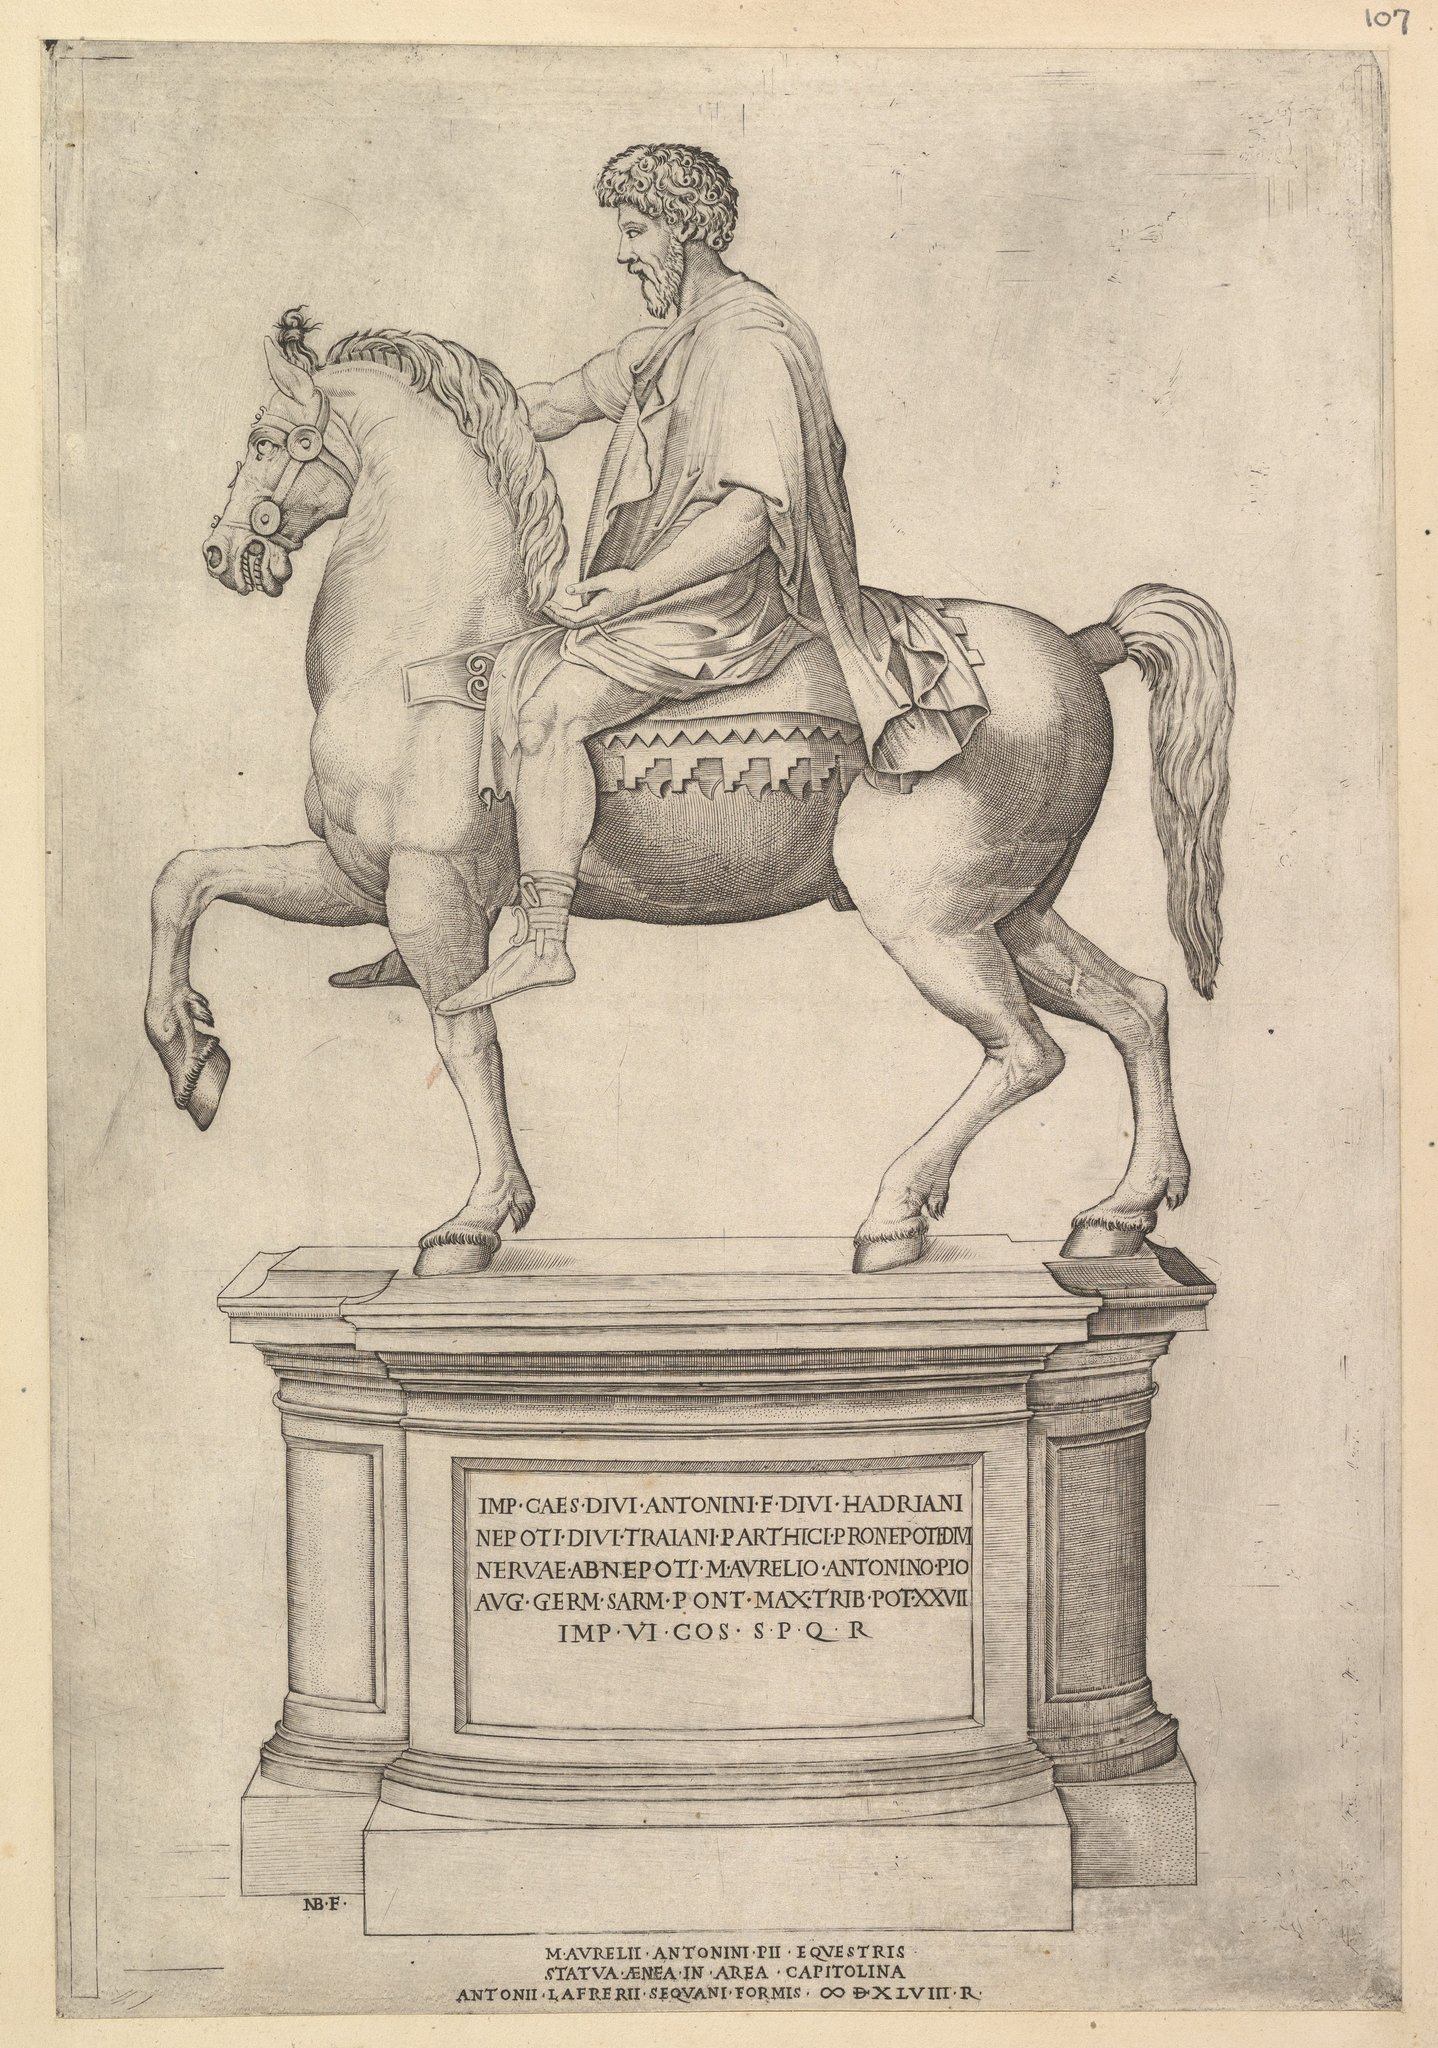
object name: print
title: Marcus Aurelius, from "Speculum Romanae Magnificentiae"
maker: nicolas beatrizet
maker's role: artist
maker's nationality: french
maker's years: 1515-1566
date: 1501-1600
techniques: engraving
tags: men,horses